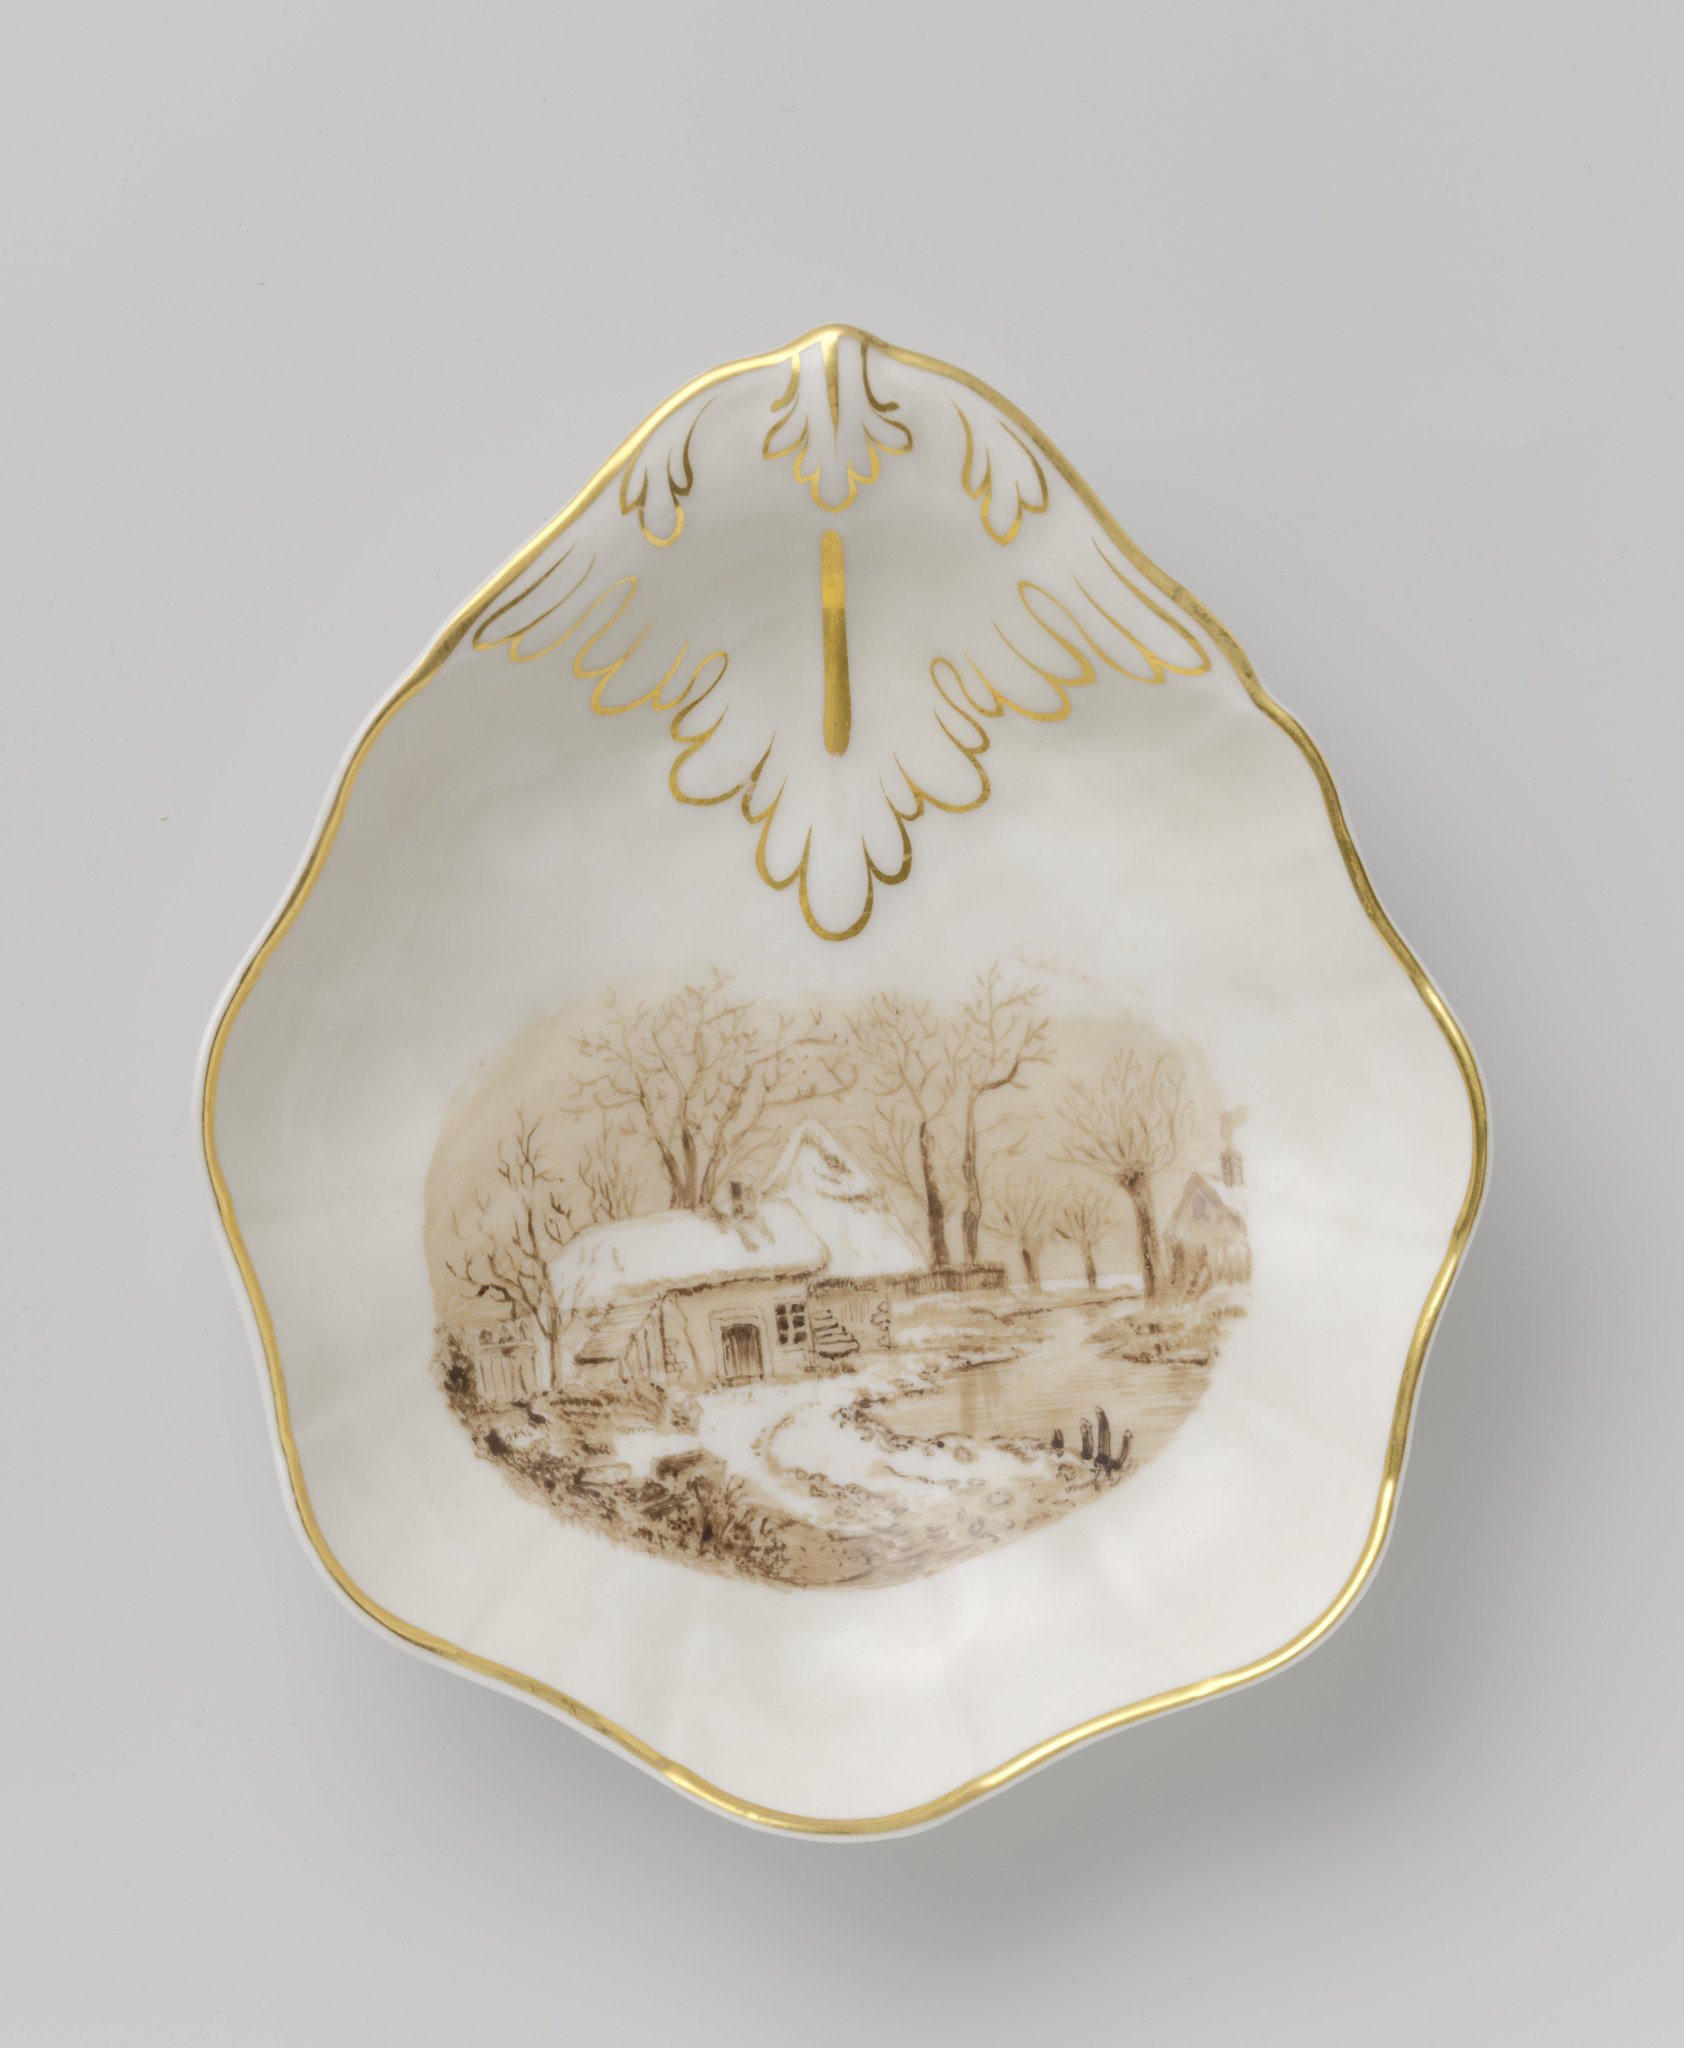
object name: dish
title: Dish with a landscape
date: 1850-1860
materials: glaze, gold, paint, porcelain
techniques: firing, forming, gilding, turning, vitrification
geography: europe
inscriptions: signature: ‘A.T.V.’, mark: ‘V?’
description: Bladvormige schaal van porselein, beschilderd op het glazuur in sepia en goud. Op de smalle zijde een gemodelleerd blad, aangezet met goud. Op het plat een winterlandschap met kale bomen en besneeuwde huizen langs een rivier. Gouden rand. Gesigneerd in de voorstelling met A.T.V. en gemerkt op de onderzijde met V[?].